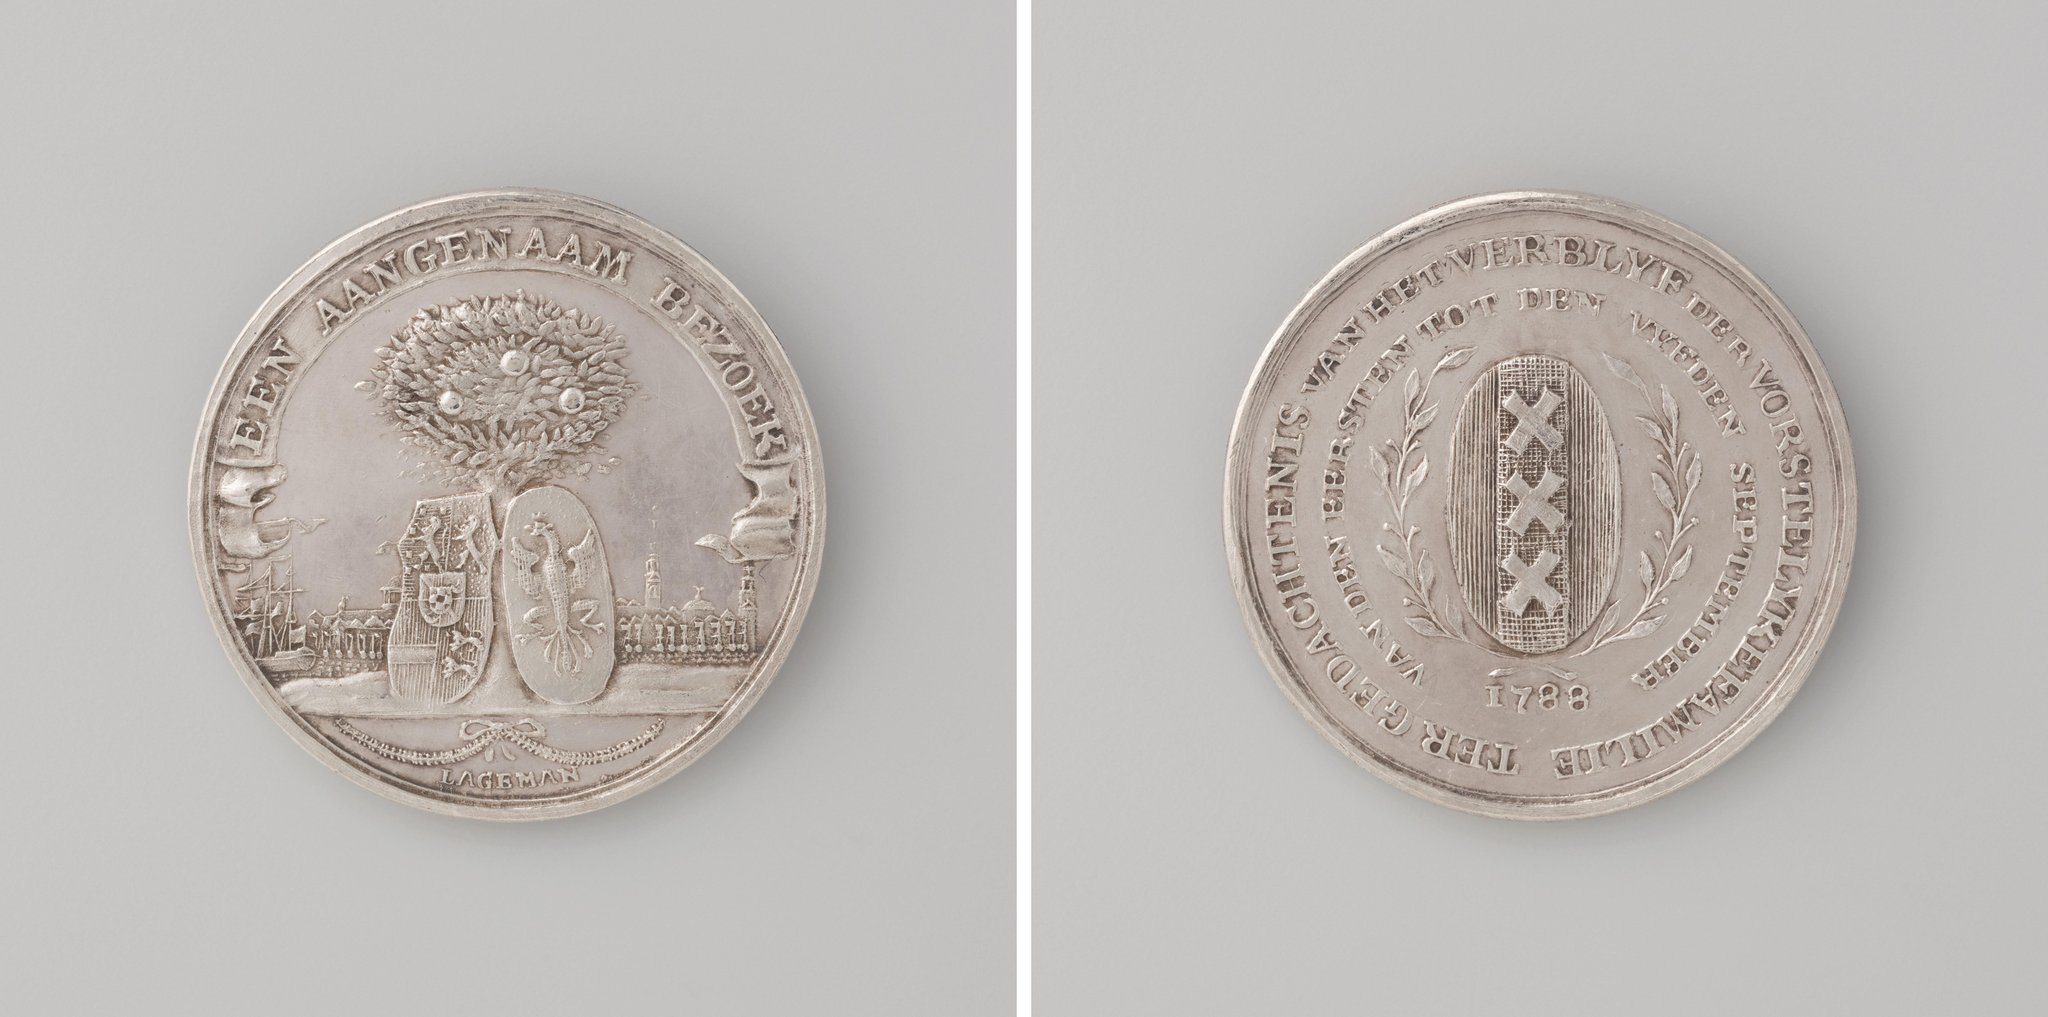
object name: history medal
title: Verblijf van de stadhouderlijke familie te Amsterdam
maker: johannes michiel lageman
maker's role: silversmith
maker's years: 1735-1809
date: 1788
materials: silver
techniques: striking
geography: amsterdam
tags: amsterdam